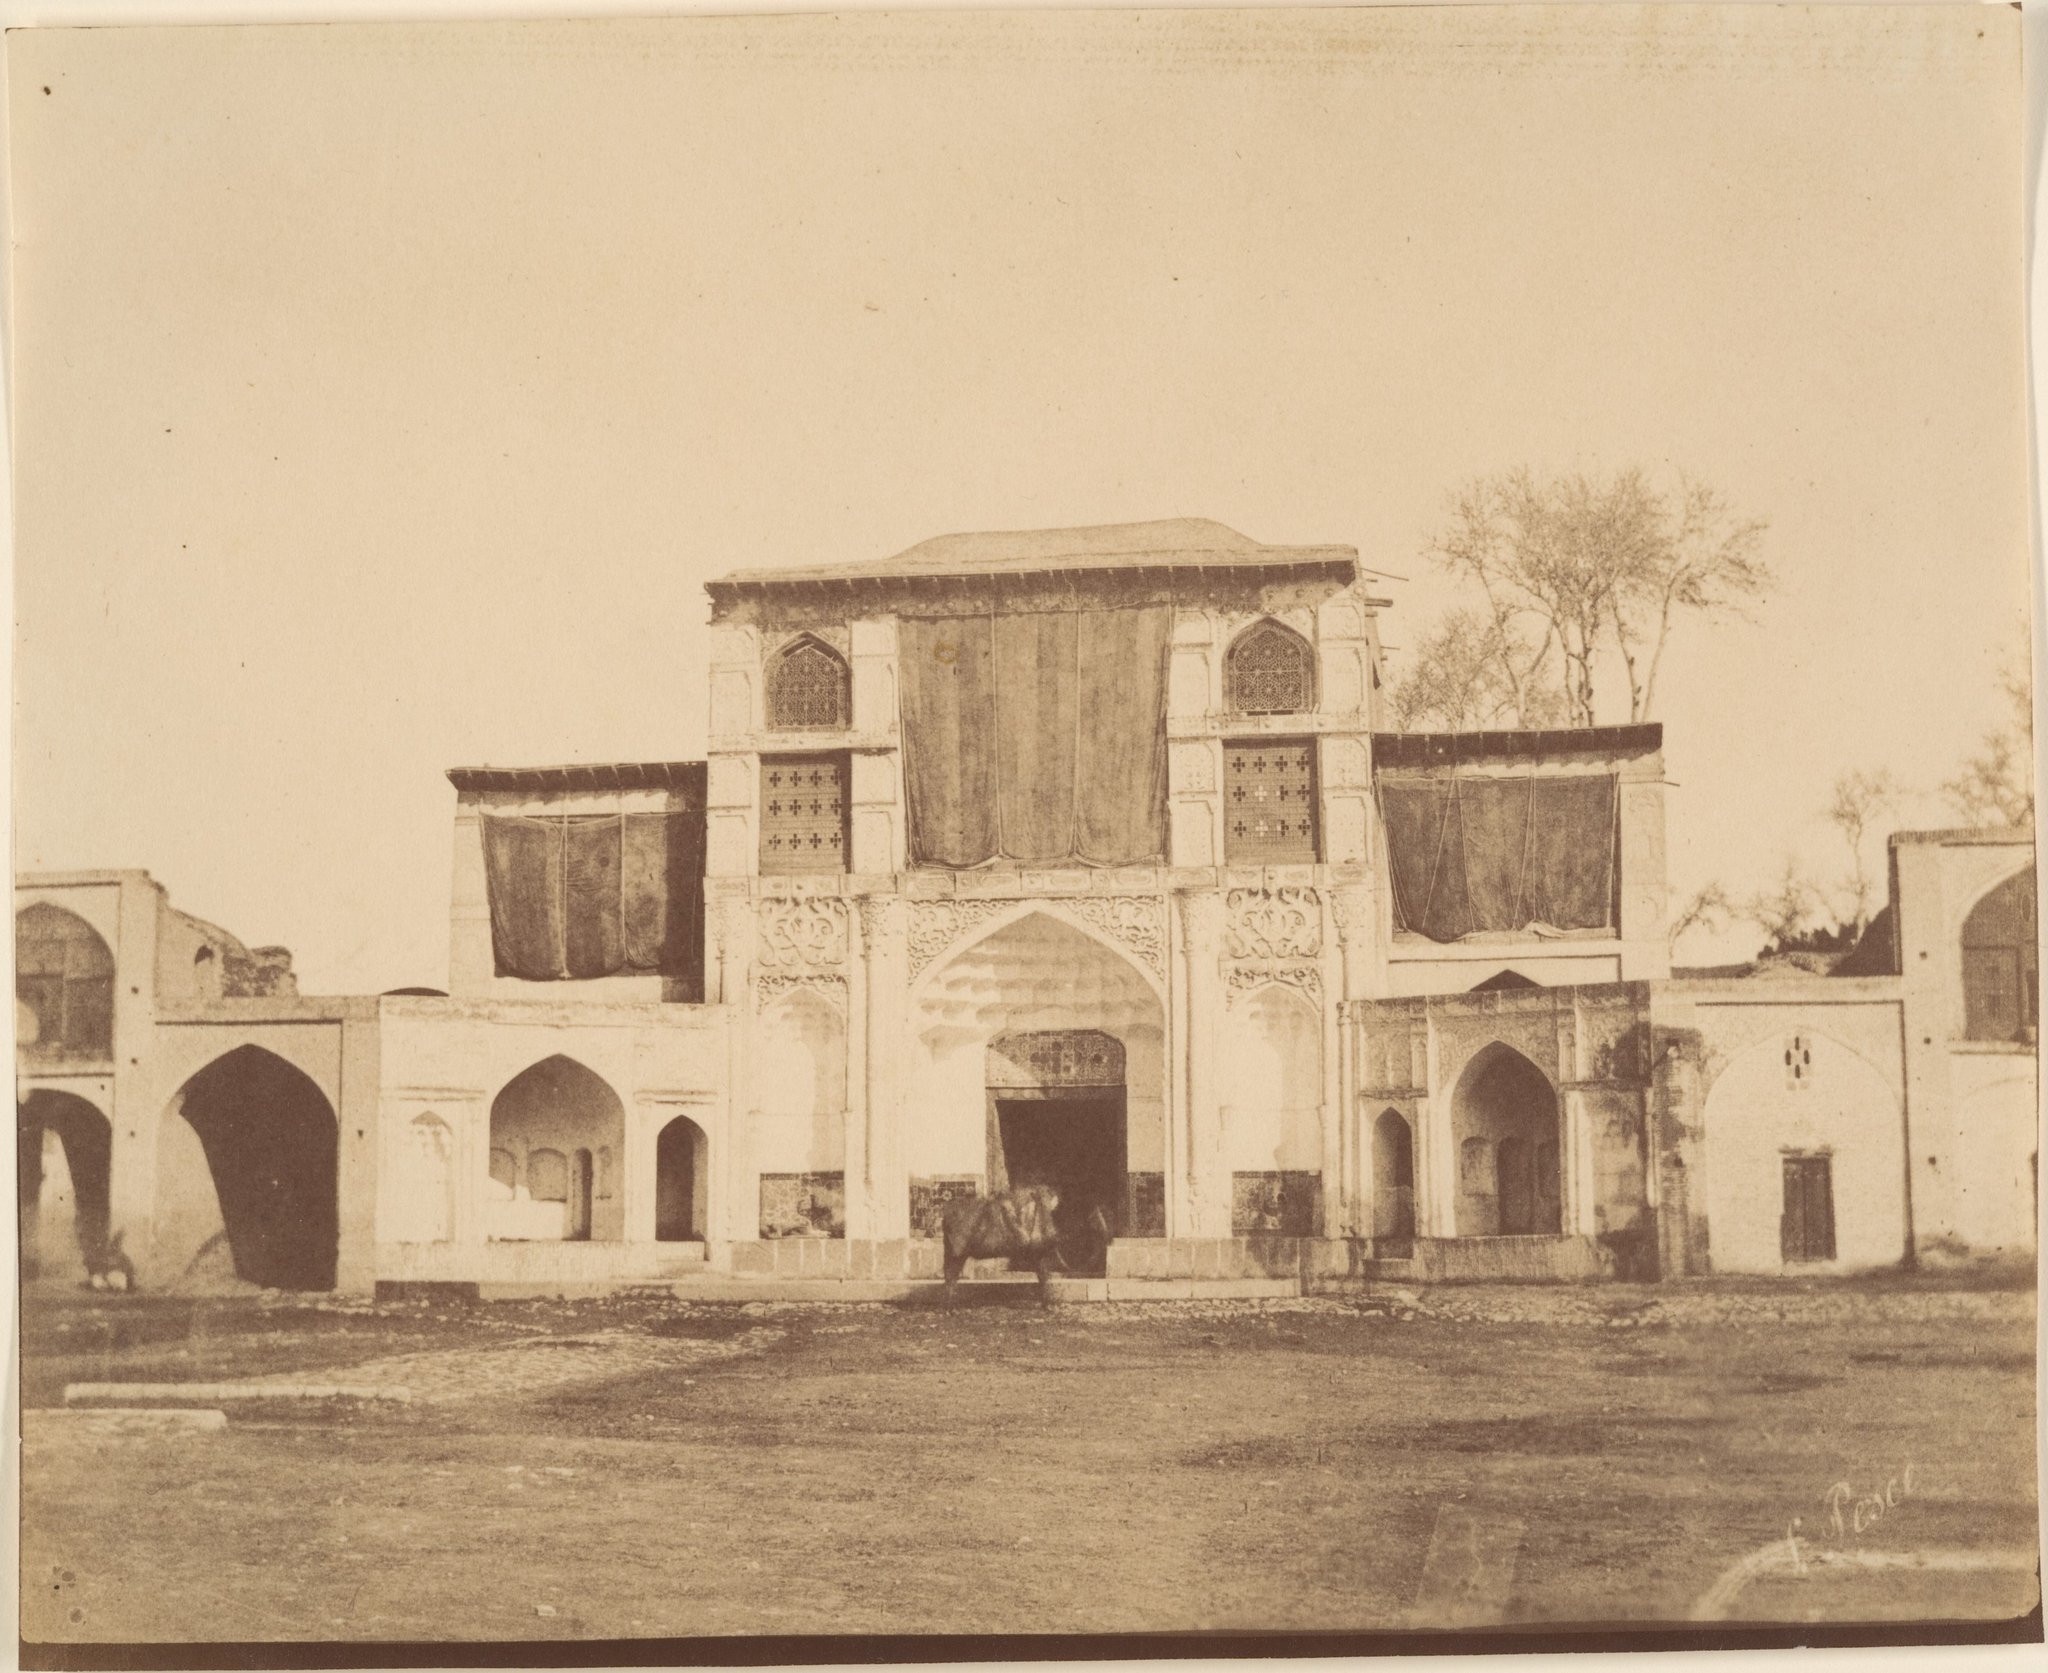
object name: photograph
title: [The Sublime Porte, Teheran, Iran]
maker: luigi pesce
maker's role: artist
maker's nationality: italian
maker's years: 1818-1891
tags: architecture